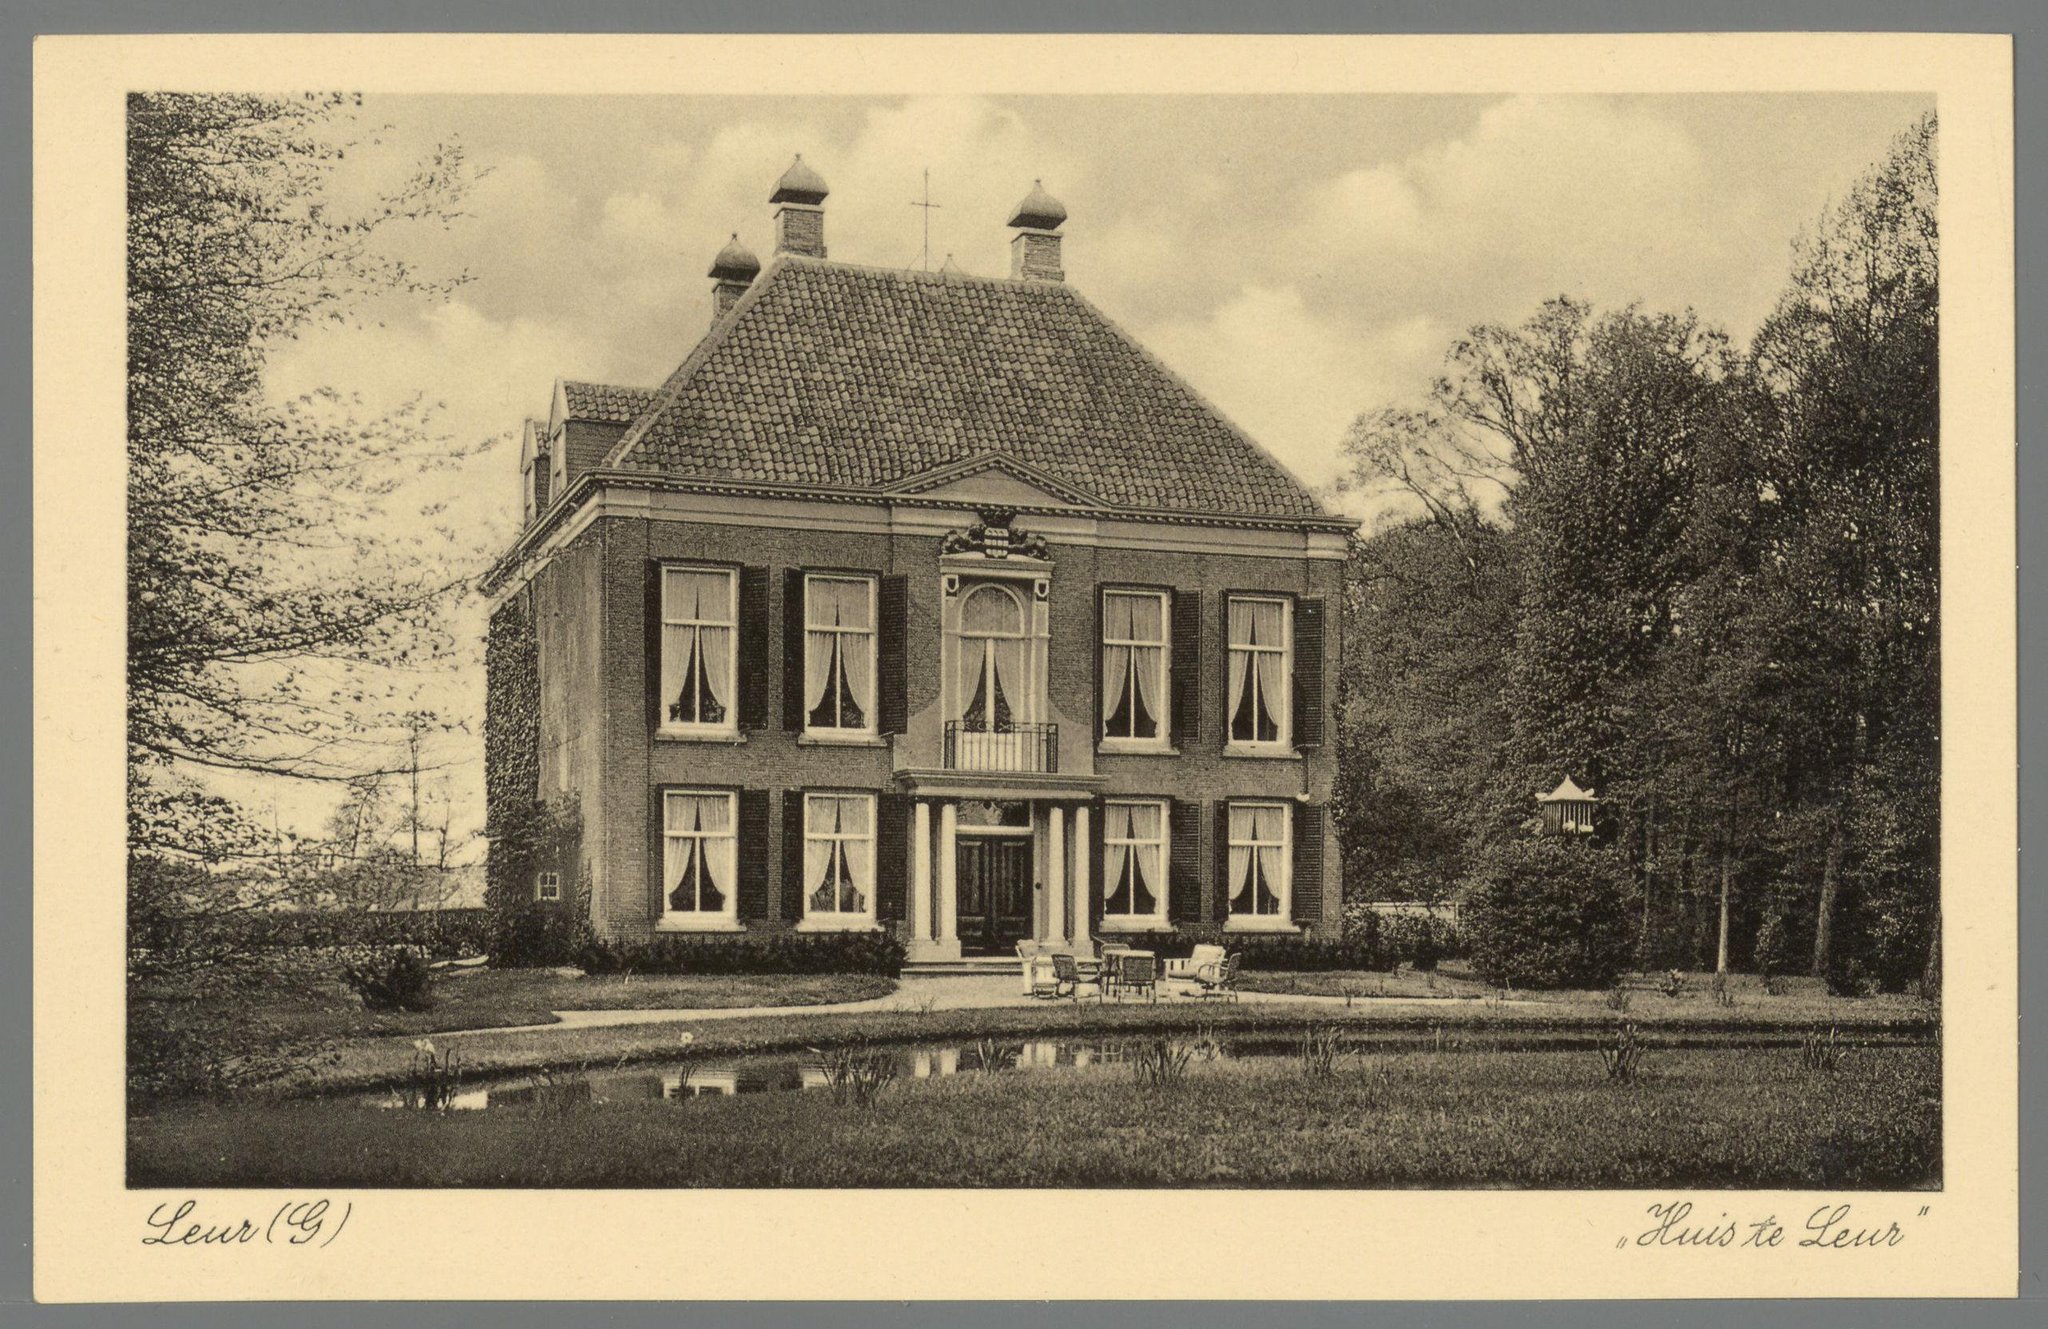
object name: photomechanical print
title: Leur (G). "Huis te Leur"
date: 1913-1950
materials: cardboard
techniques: photograph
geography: wijchen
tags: villa